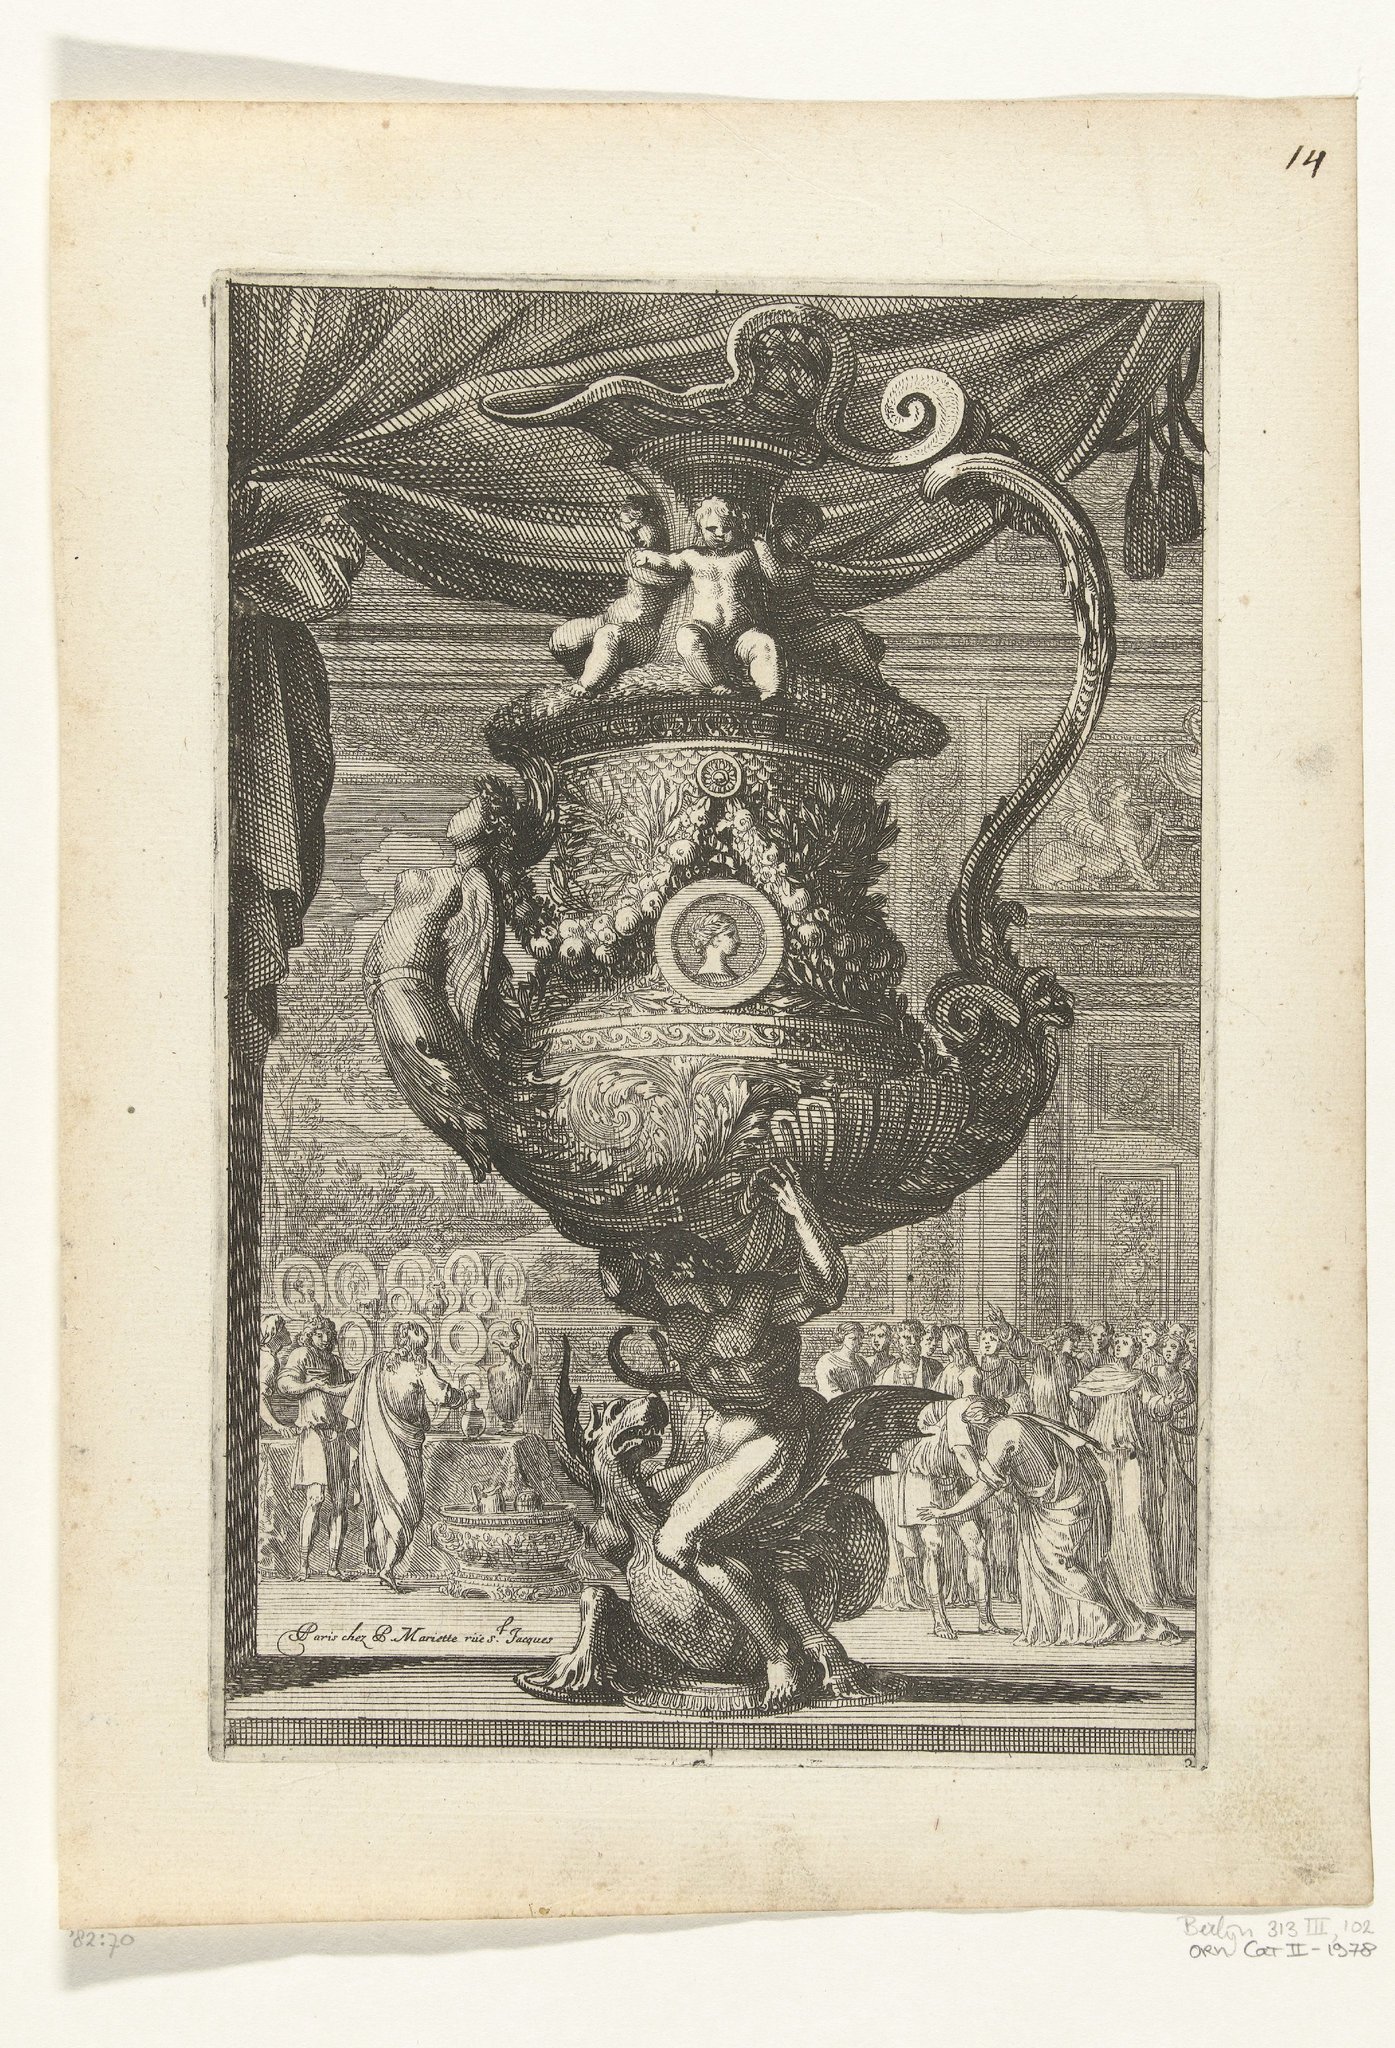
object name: ornament print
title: Vases à la moderne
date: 1659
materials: paper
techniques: etching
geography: france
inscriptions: number: ‘14’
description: De kan heeft een voet in de vorm van een jongeman zittend op een draak.